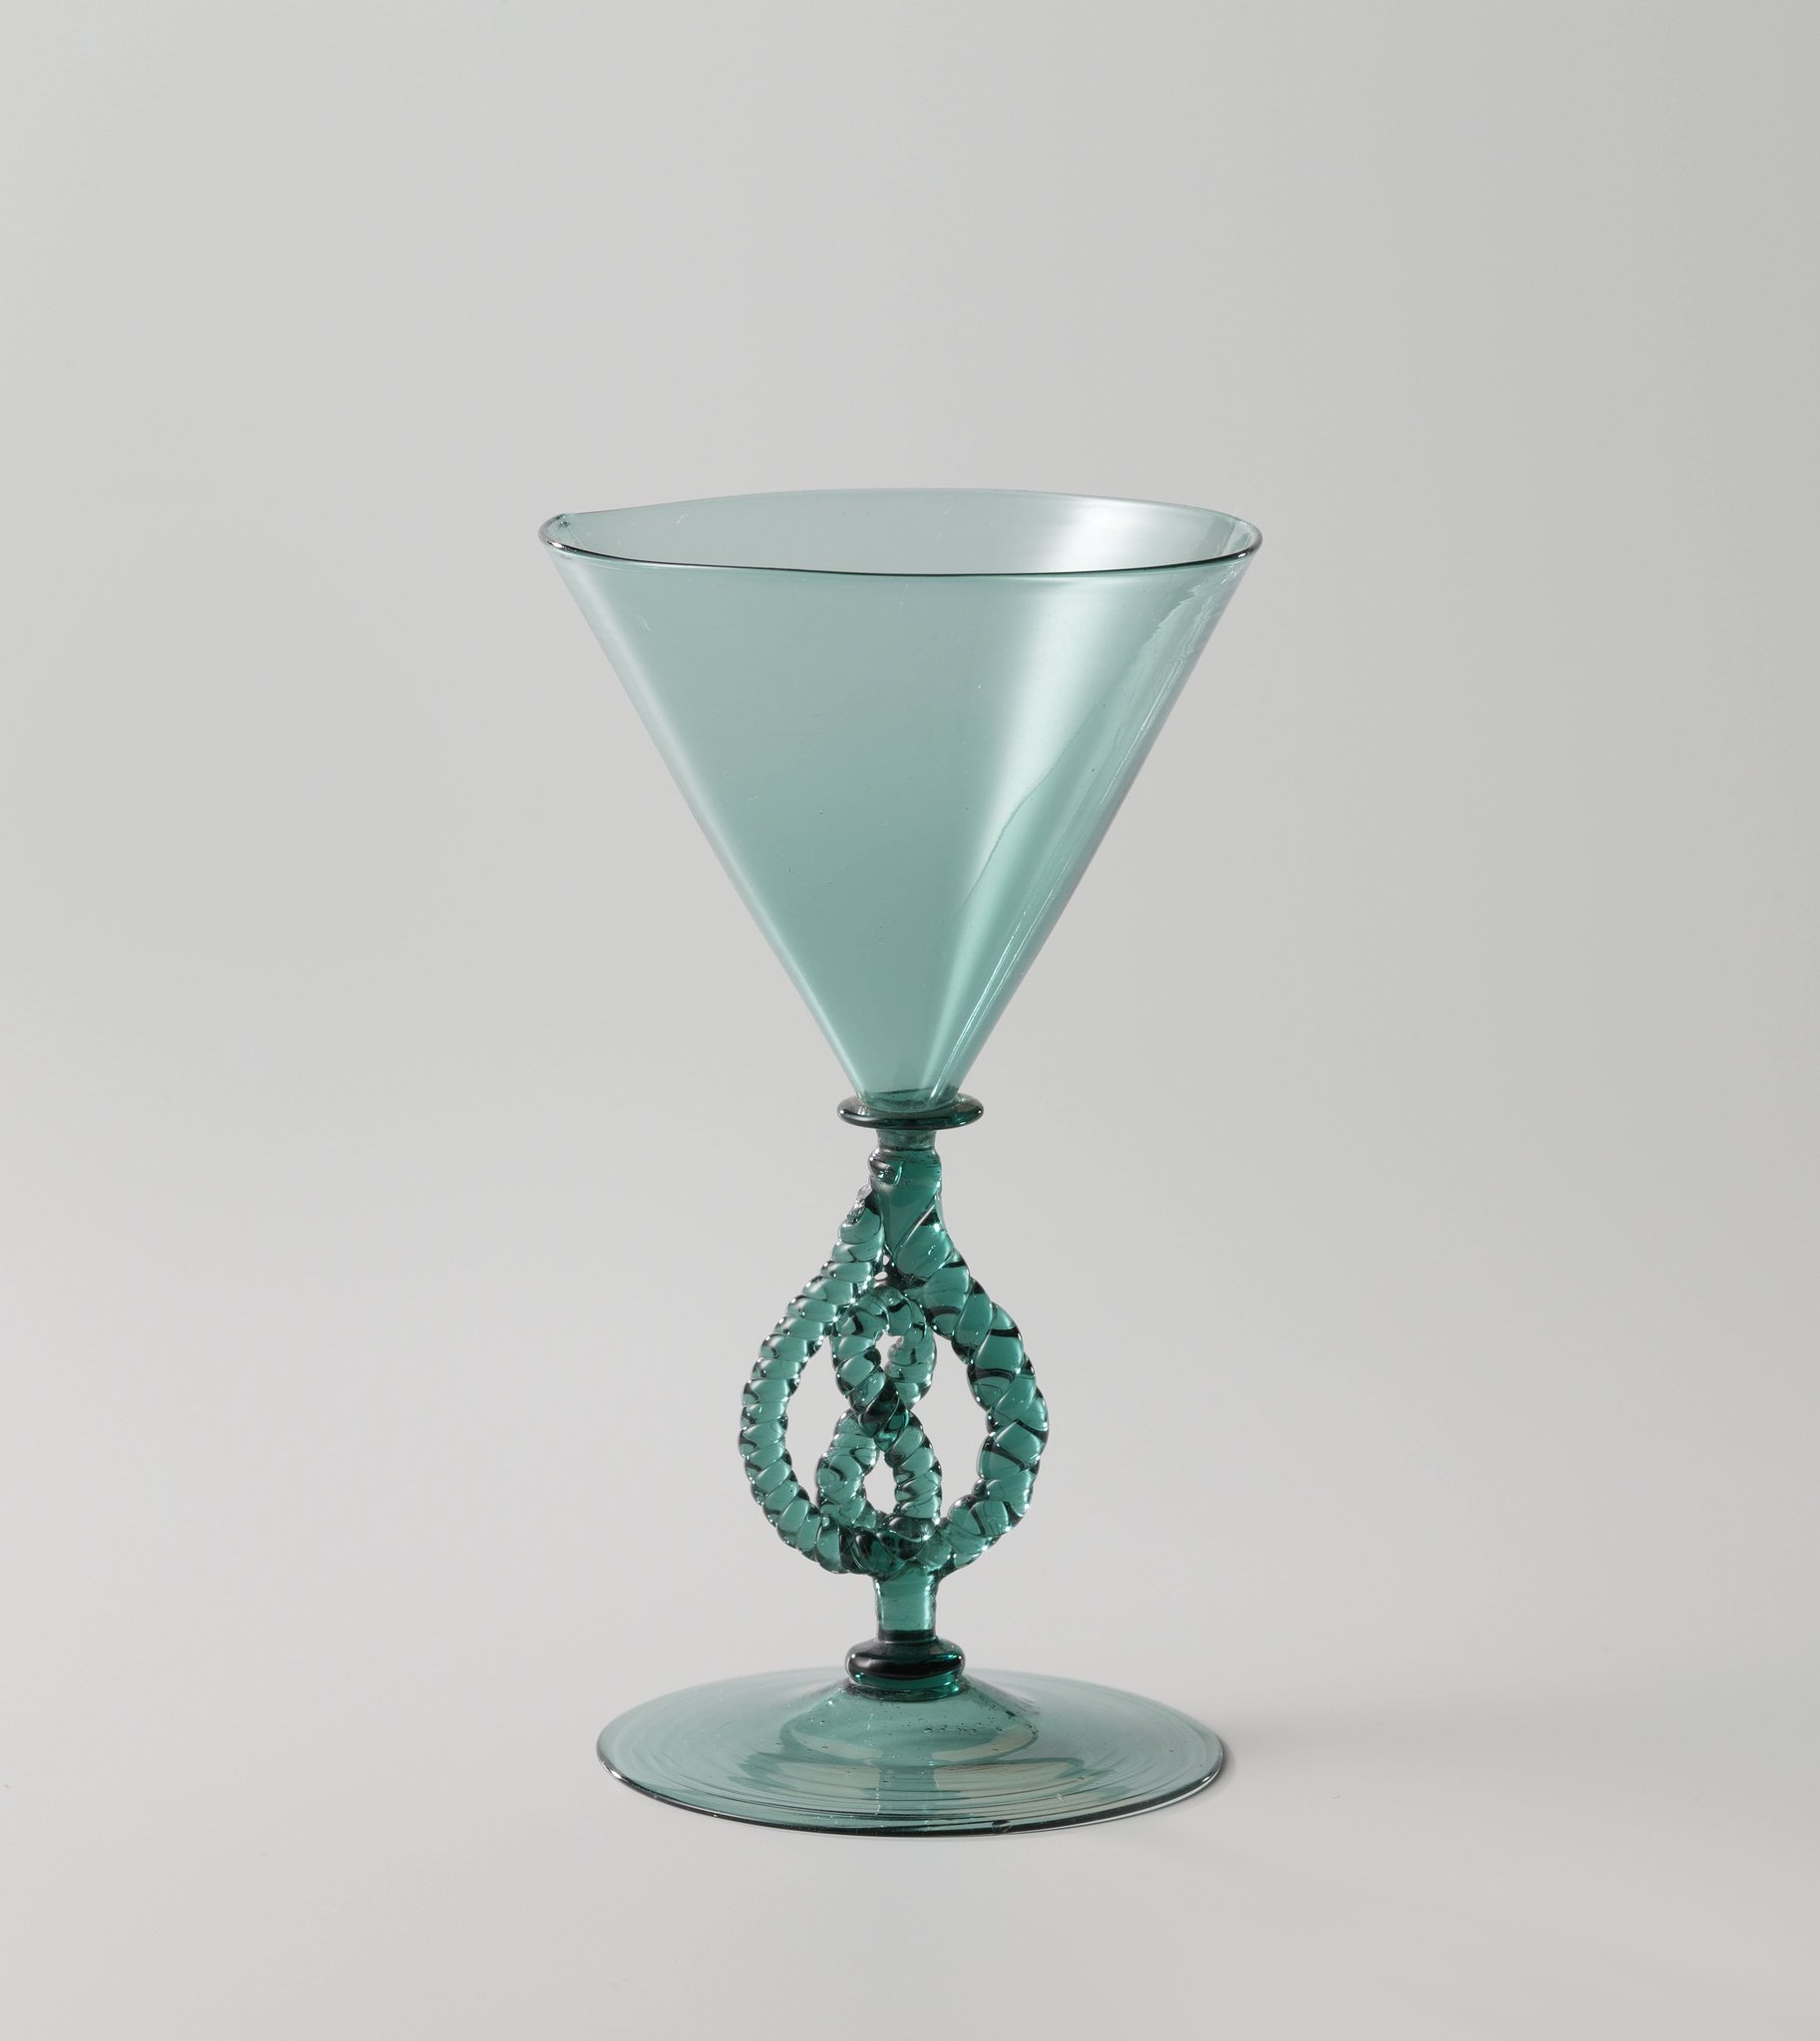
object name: serpent stem glass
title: Slangenglas met trechtervormige kelk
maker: Anonymous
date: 1600-1700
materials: glass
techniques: glassblowing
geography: venice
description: Kelkglas van helder groen glas. Platte voet. De stam opgebouwd uit een getordeerde in lussen gelegde draad. Trechtervormige kelk.